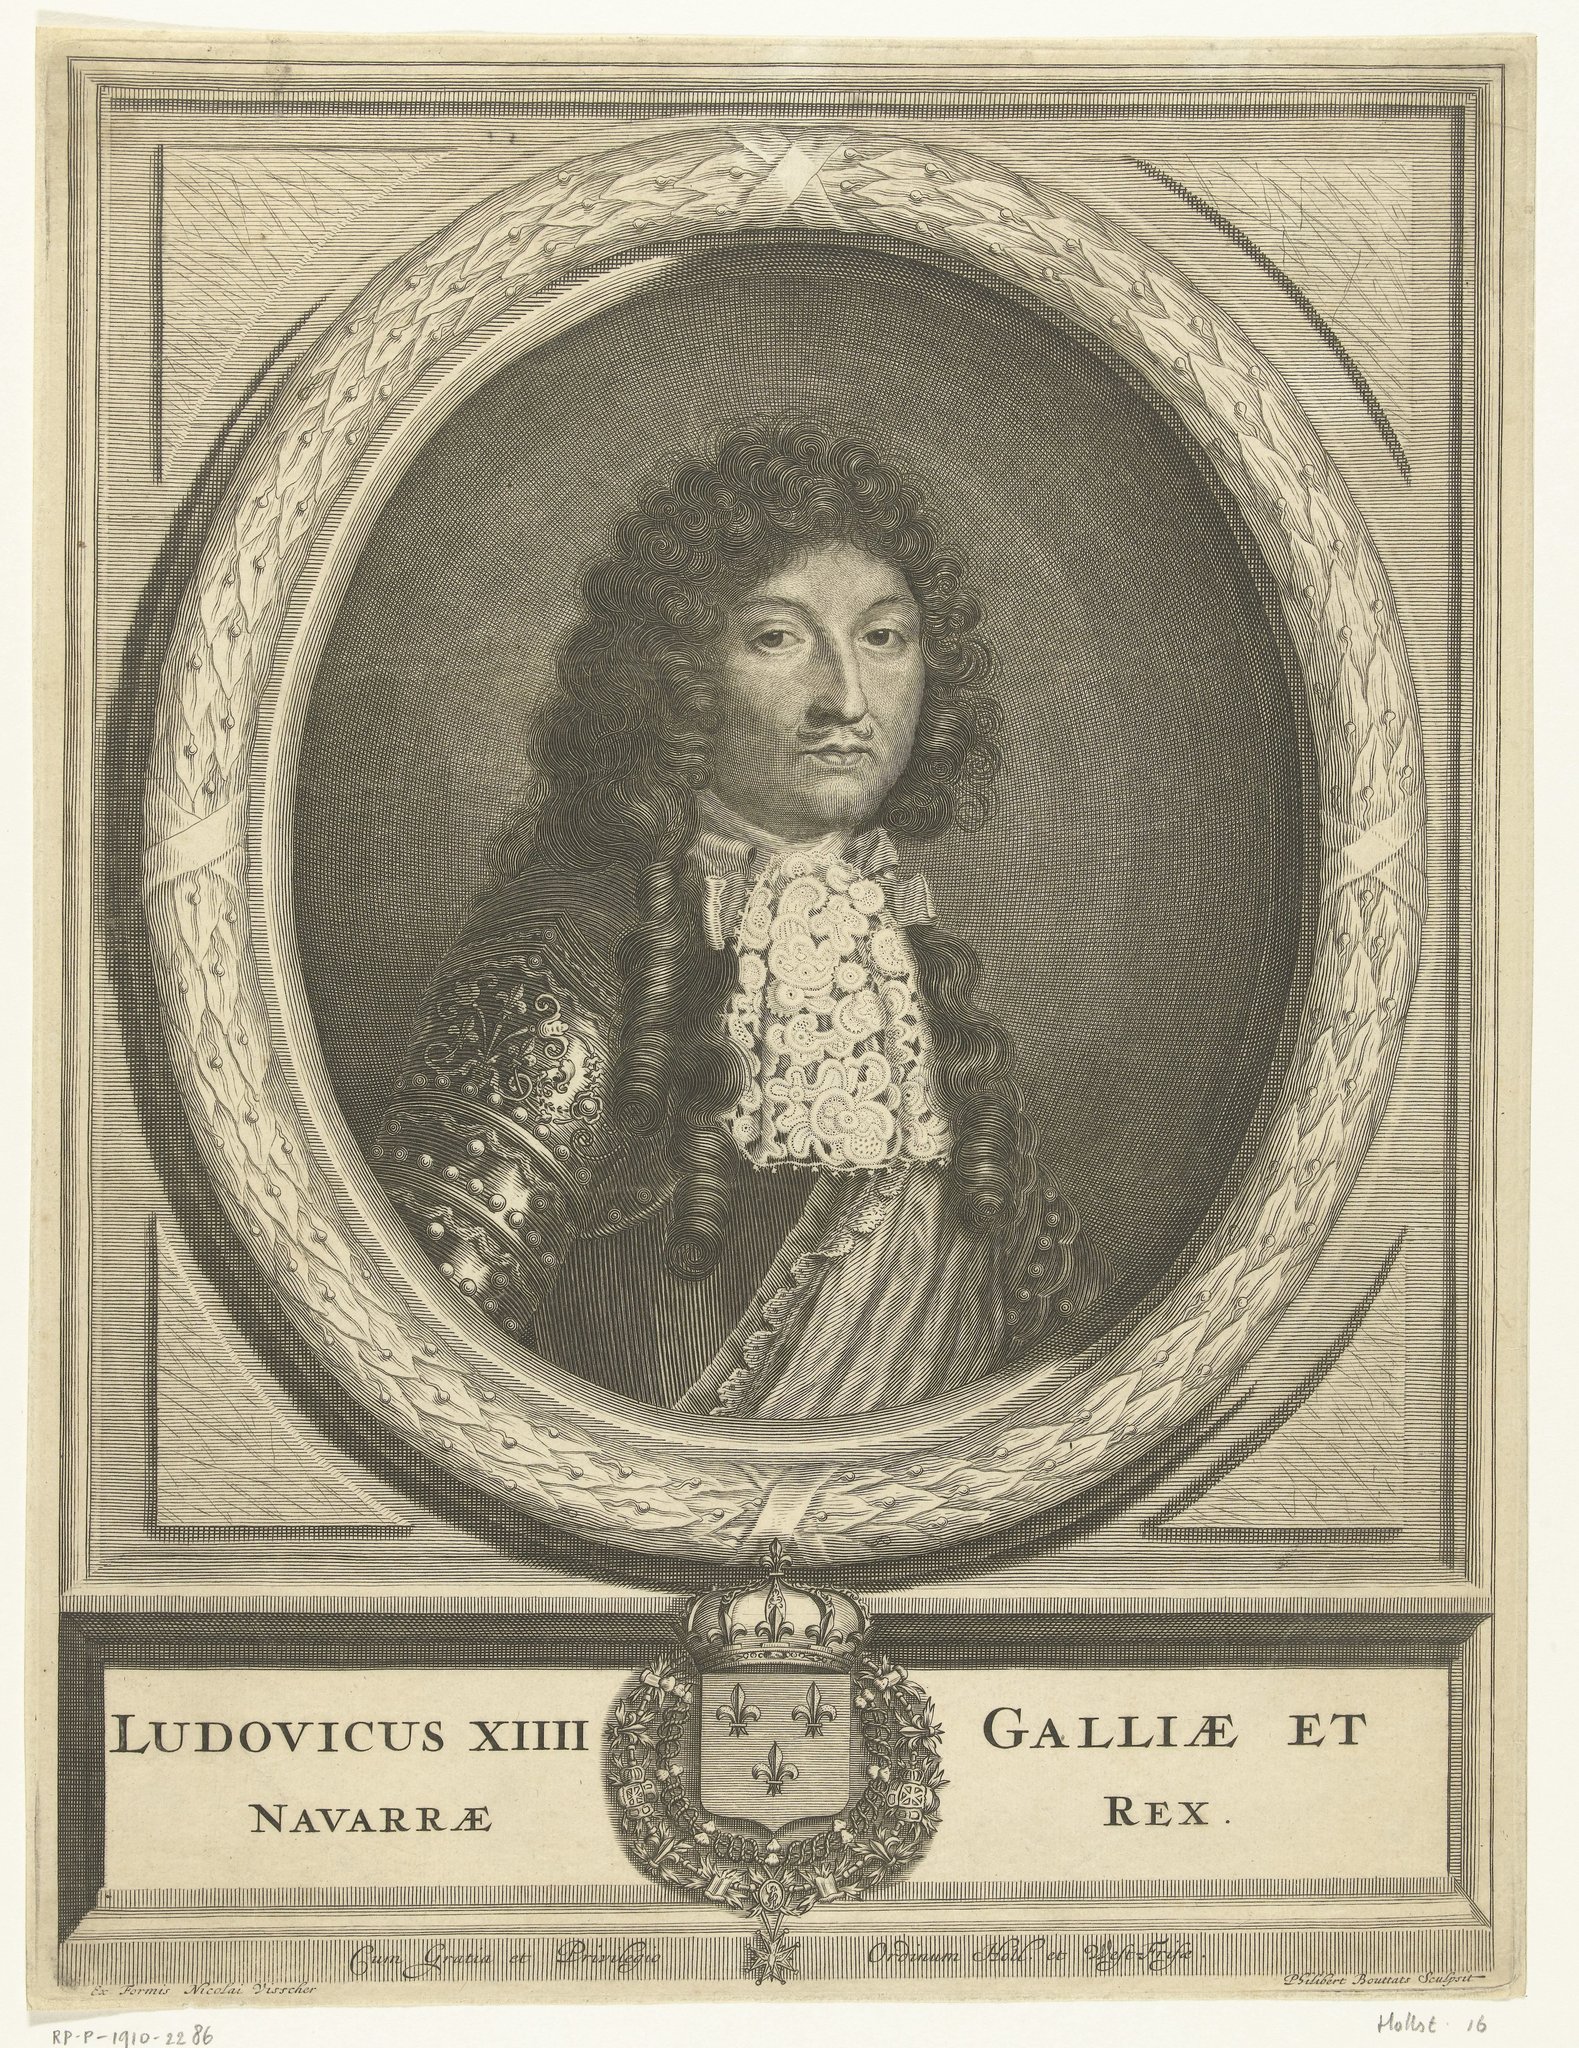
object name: print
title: Portret van Lodewijk XIV, koning van Frankrijk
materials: paper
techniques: engraving, etching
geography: netherlands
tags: lodewijk xiv (koning van frankrijk), historical persons, piece of clothing covering the breast or décolleté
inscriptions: address: ‘Ex Formis Nicolai Visscher’, signature: ‘Philibert Bouttats Sculpsit’, title: ‘LUDOVICUS XIIII GALLIAE ET NAVARRAE REX’, collector's mark: Lugt 2228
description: Portret in ovale lijst van Lodewijk XIV, koning van Frankrijk. Buste naar rechts. Grote kanten jabot en sjerp. Haardracht van lange pijpekrullen. Wapen middenonder.